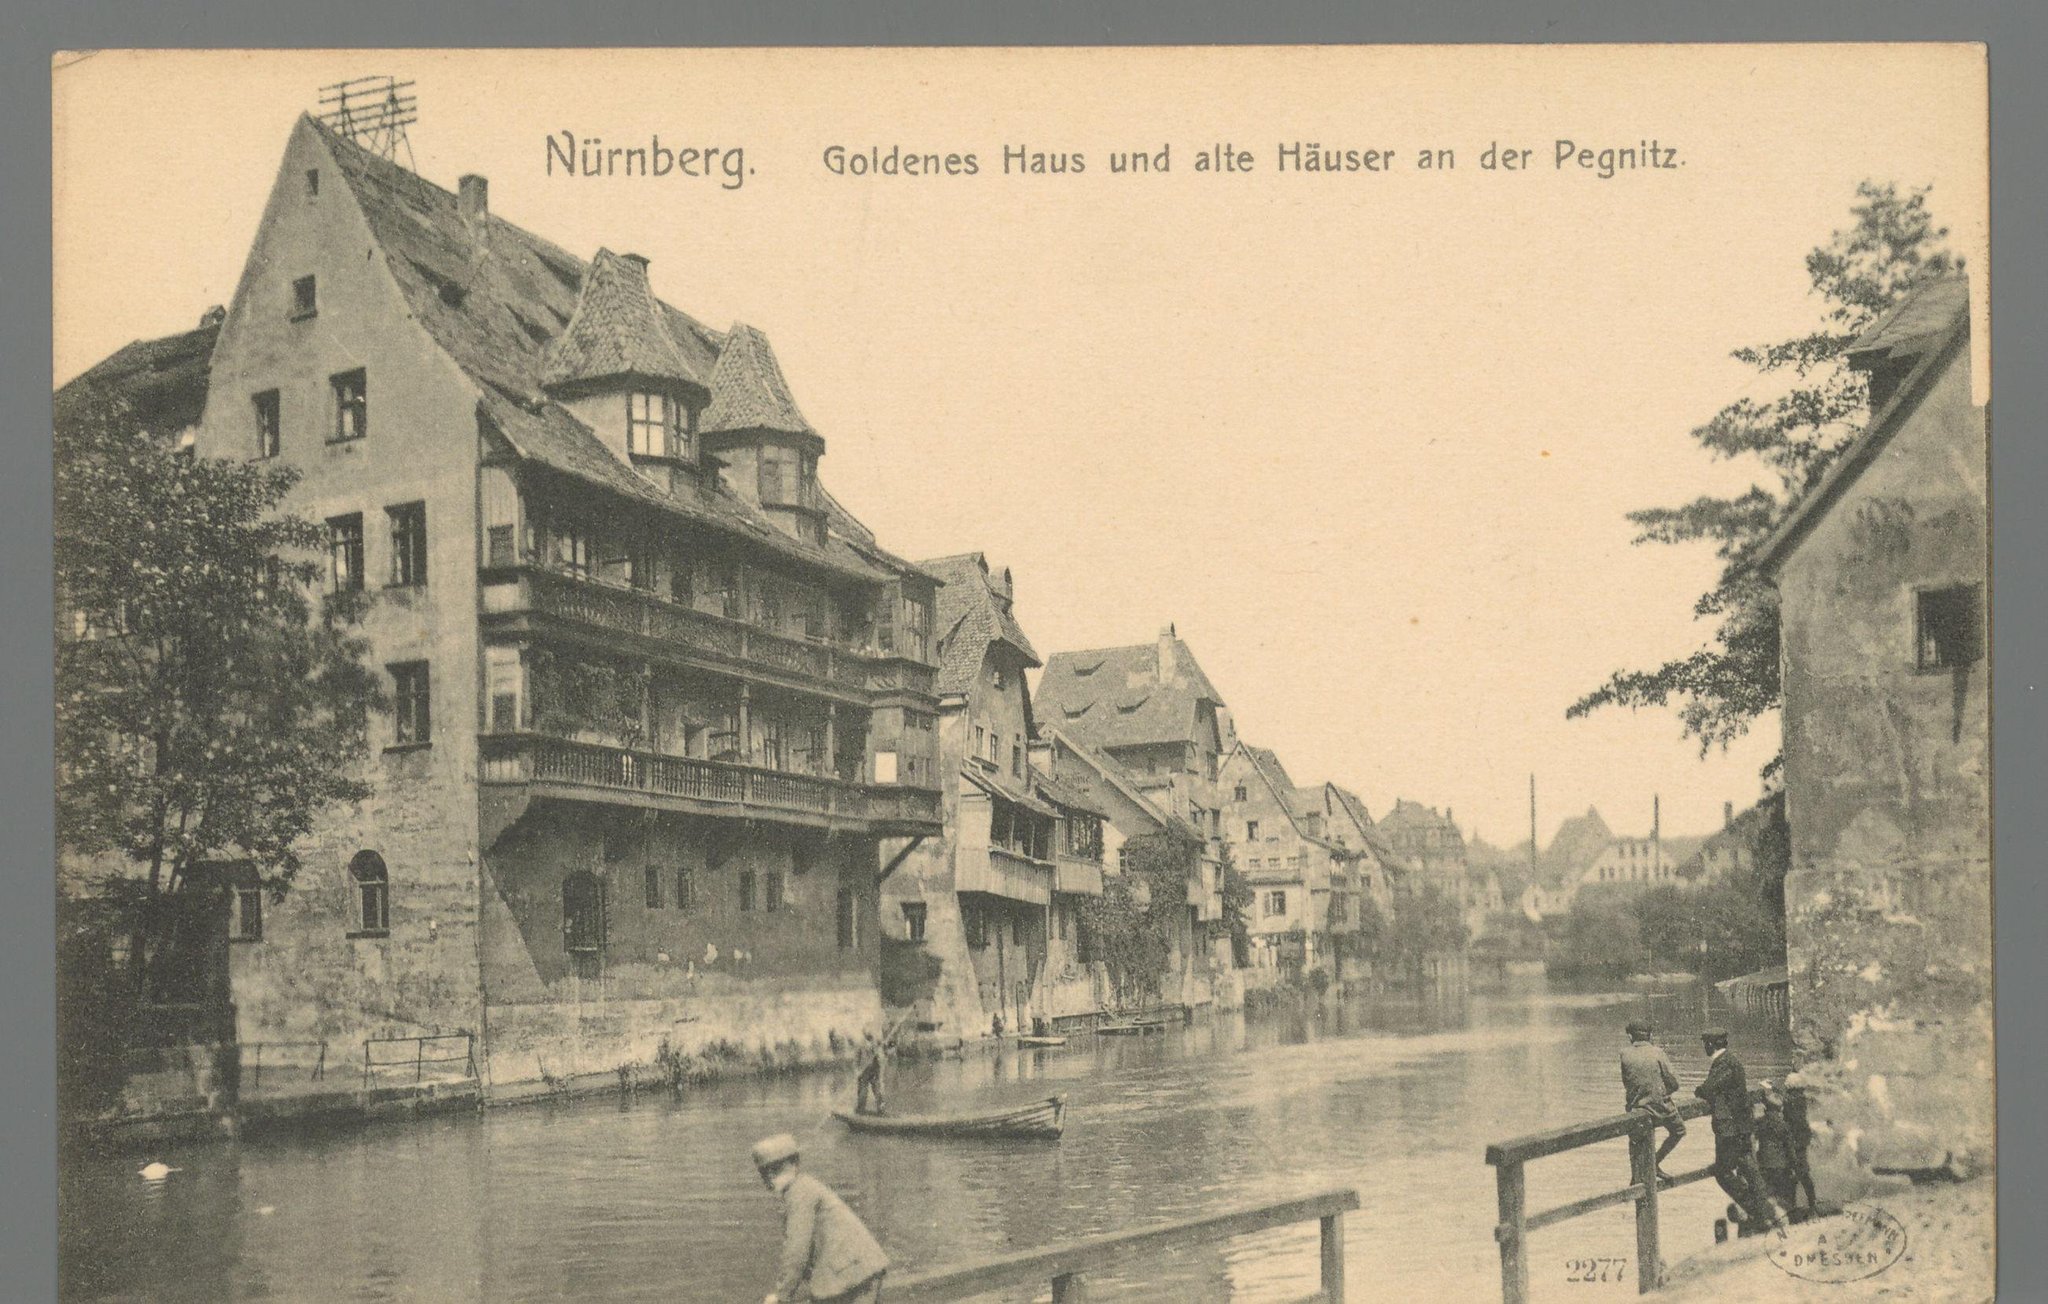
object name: photomechanical print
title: Nürnberg. Goldenes Haus und alte Häuser an der Pegnitz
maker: Anonymous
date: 1905-1930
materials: cardboard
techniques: photograph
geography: dresden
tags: canals, waters (in city), street